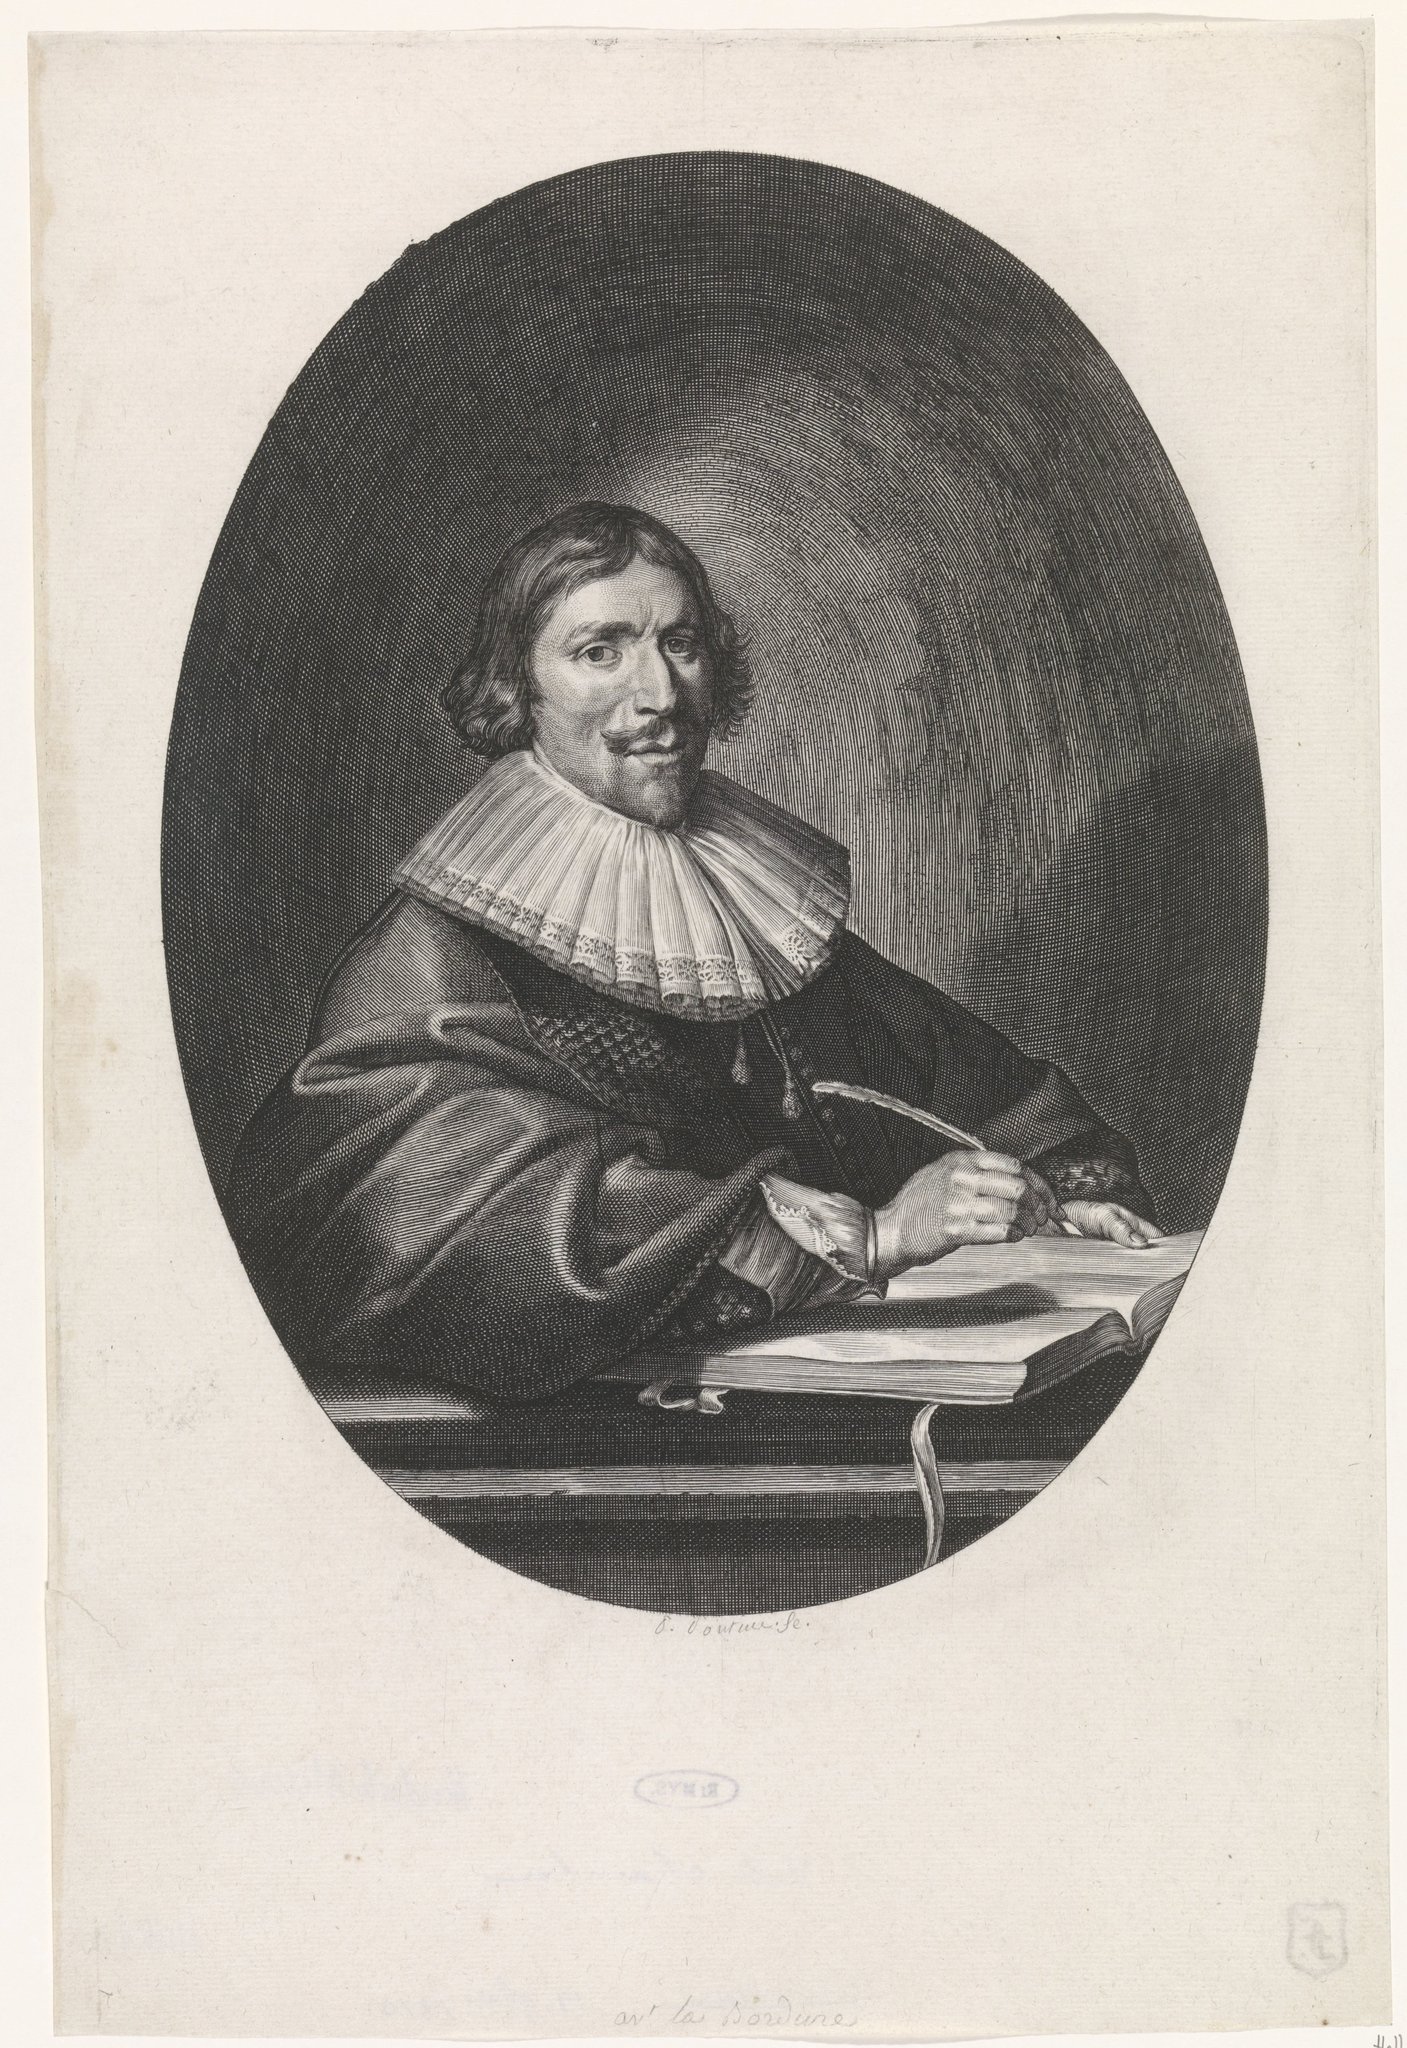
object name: print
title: Portret van Hendrik Meurs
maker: paulus pontius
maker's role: draughtsman, print maker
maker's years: 1603-1658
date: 1639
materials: paper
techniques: engraving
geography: antwerp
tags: amsterdam, pen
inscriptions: collector's mark: Lugt 2228, collector's mark: Lugt 963